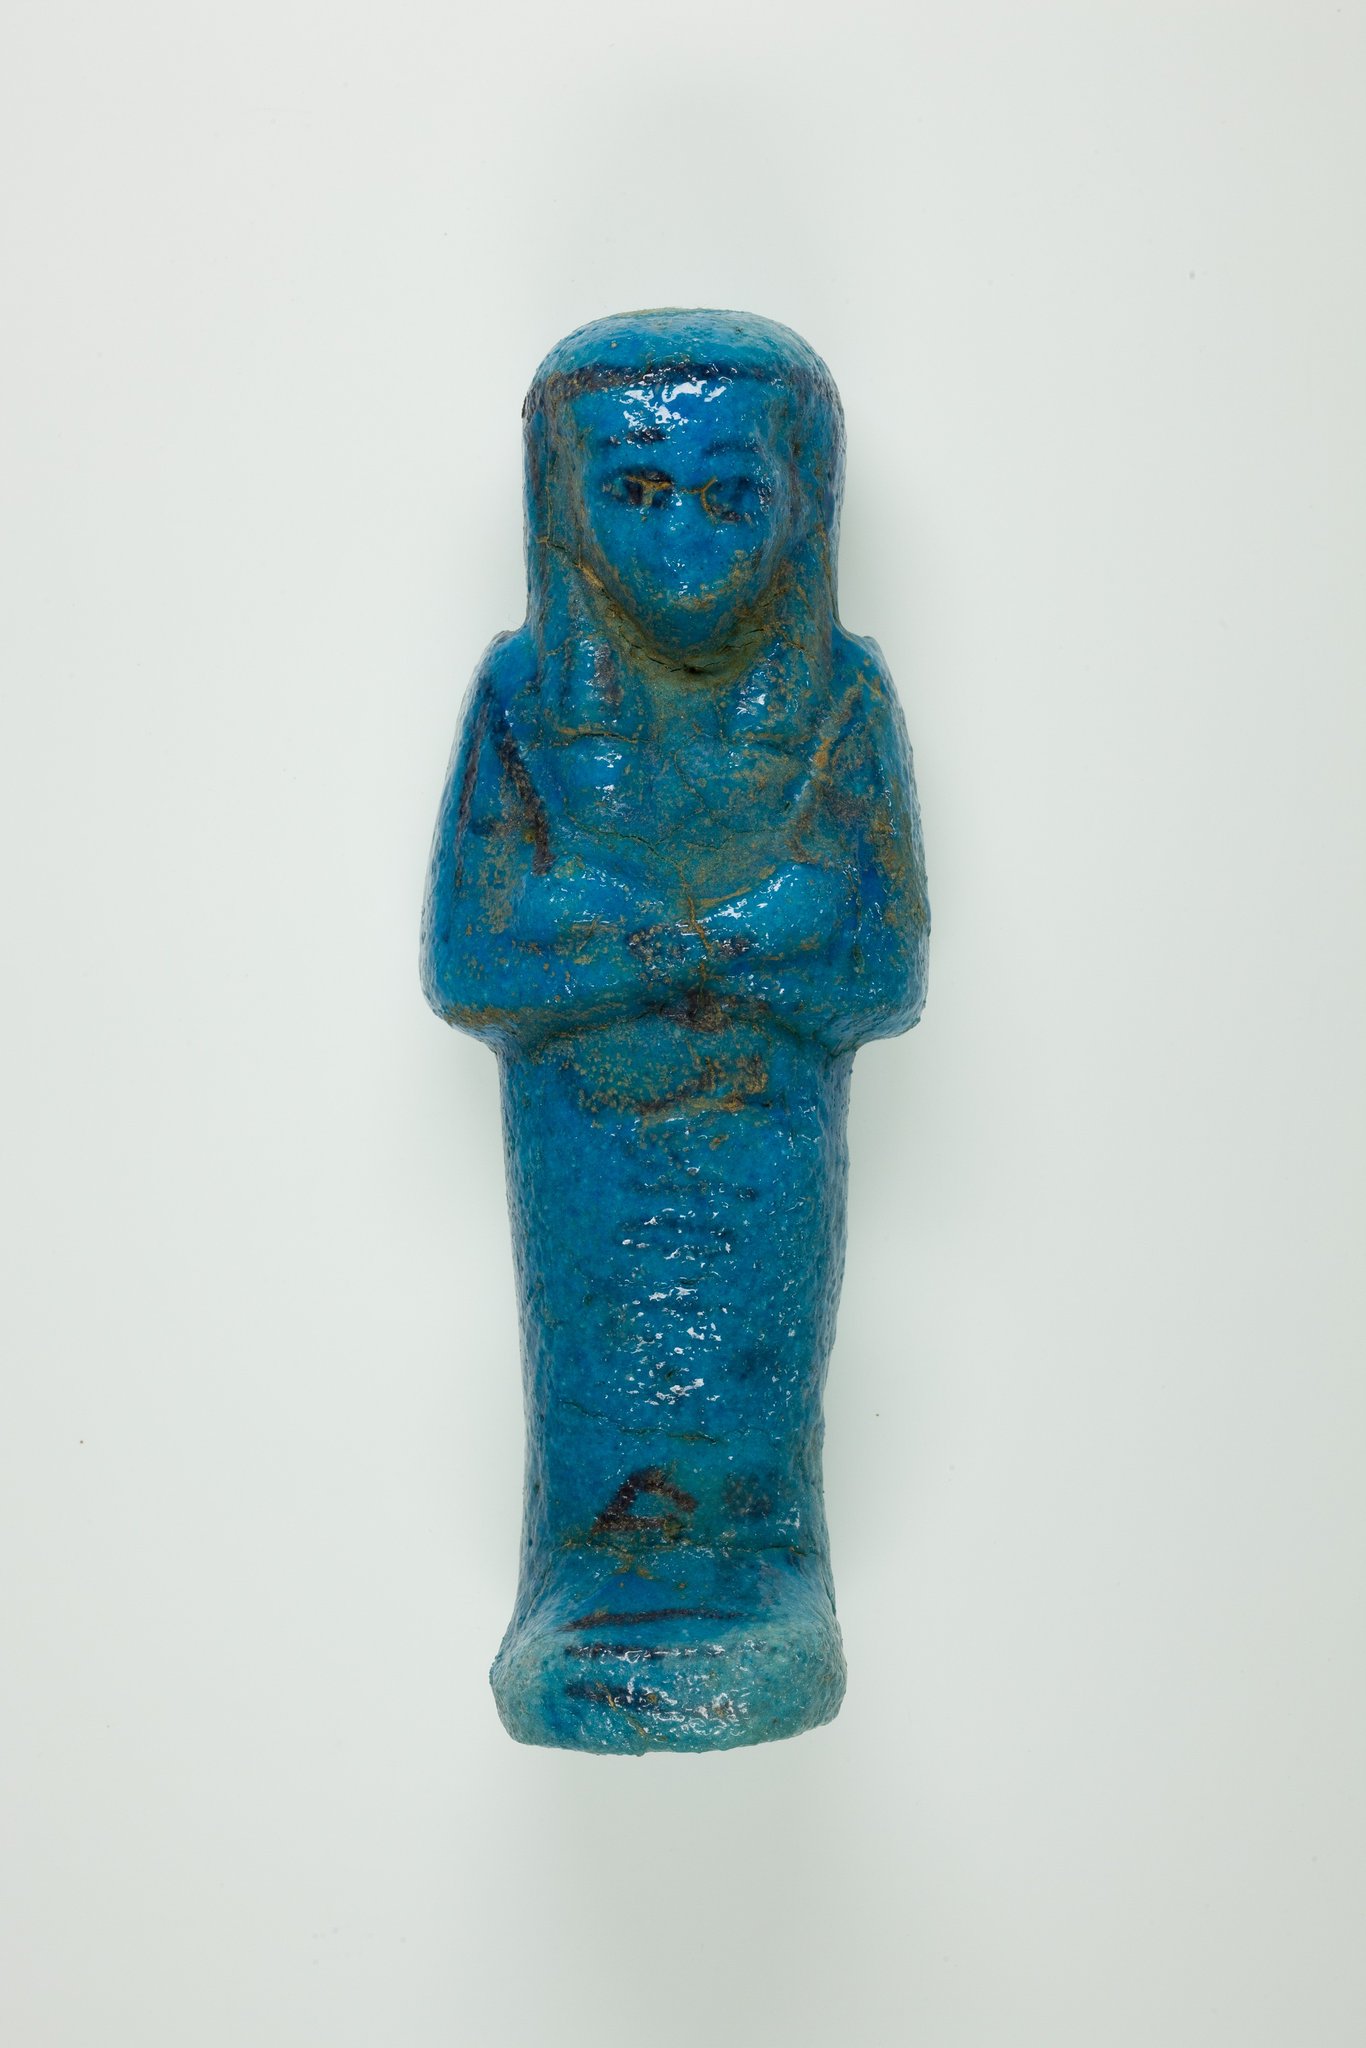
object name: worker shabti, henettawy c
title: Worker Shabti of Henettawy (C), Daughter of Isetemkheb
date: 990-970 BCE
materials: faience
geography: egypt